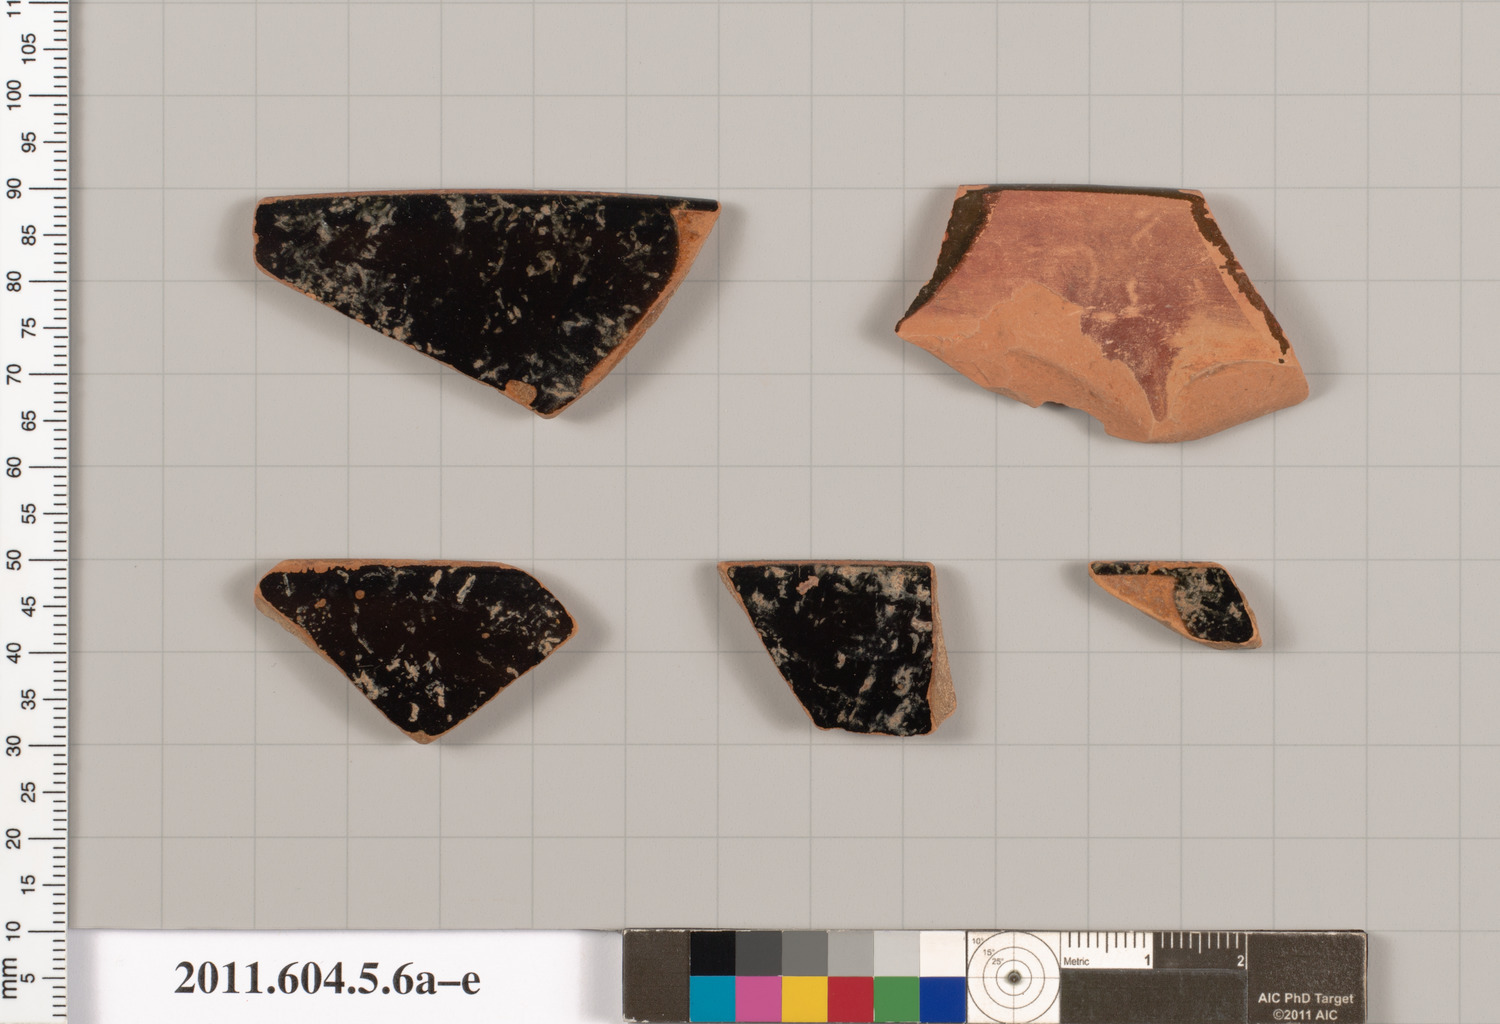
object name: kylix fragment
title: Terracotta rim fragments of kylikes (drinking cups)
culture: greek, attic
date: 475-451 BCE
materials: terracotta